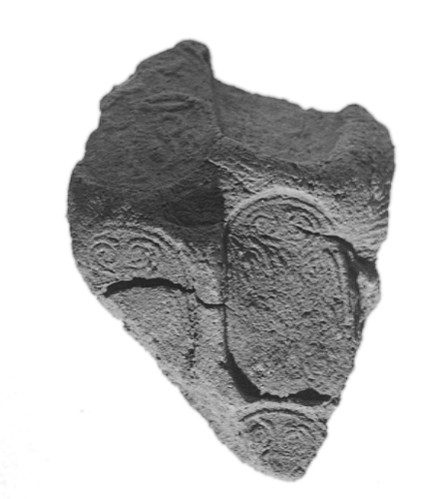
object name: sealing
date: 2030-1640 BCE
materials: clay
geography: egypt